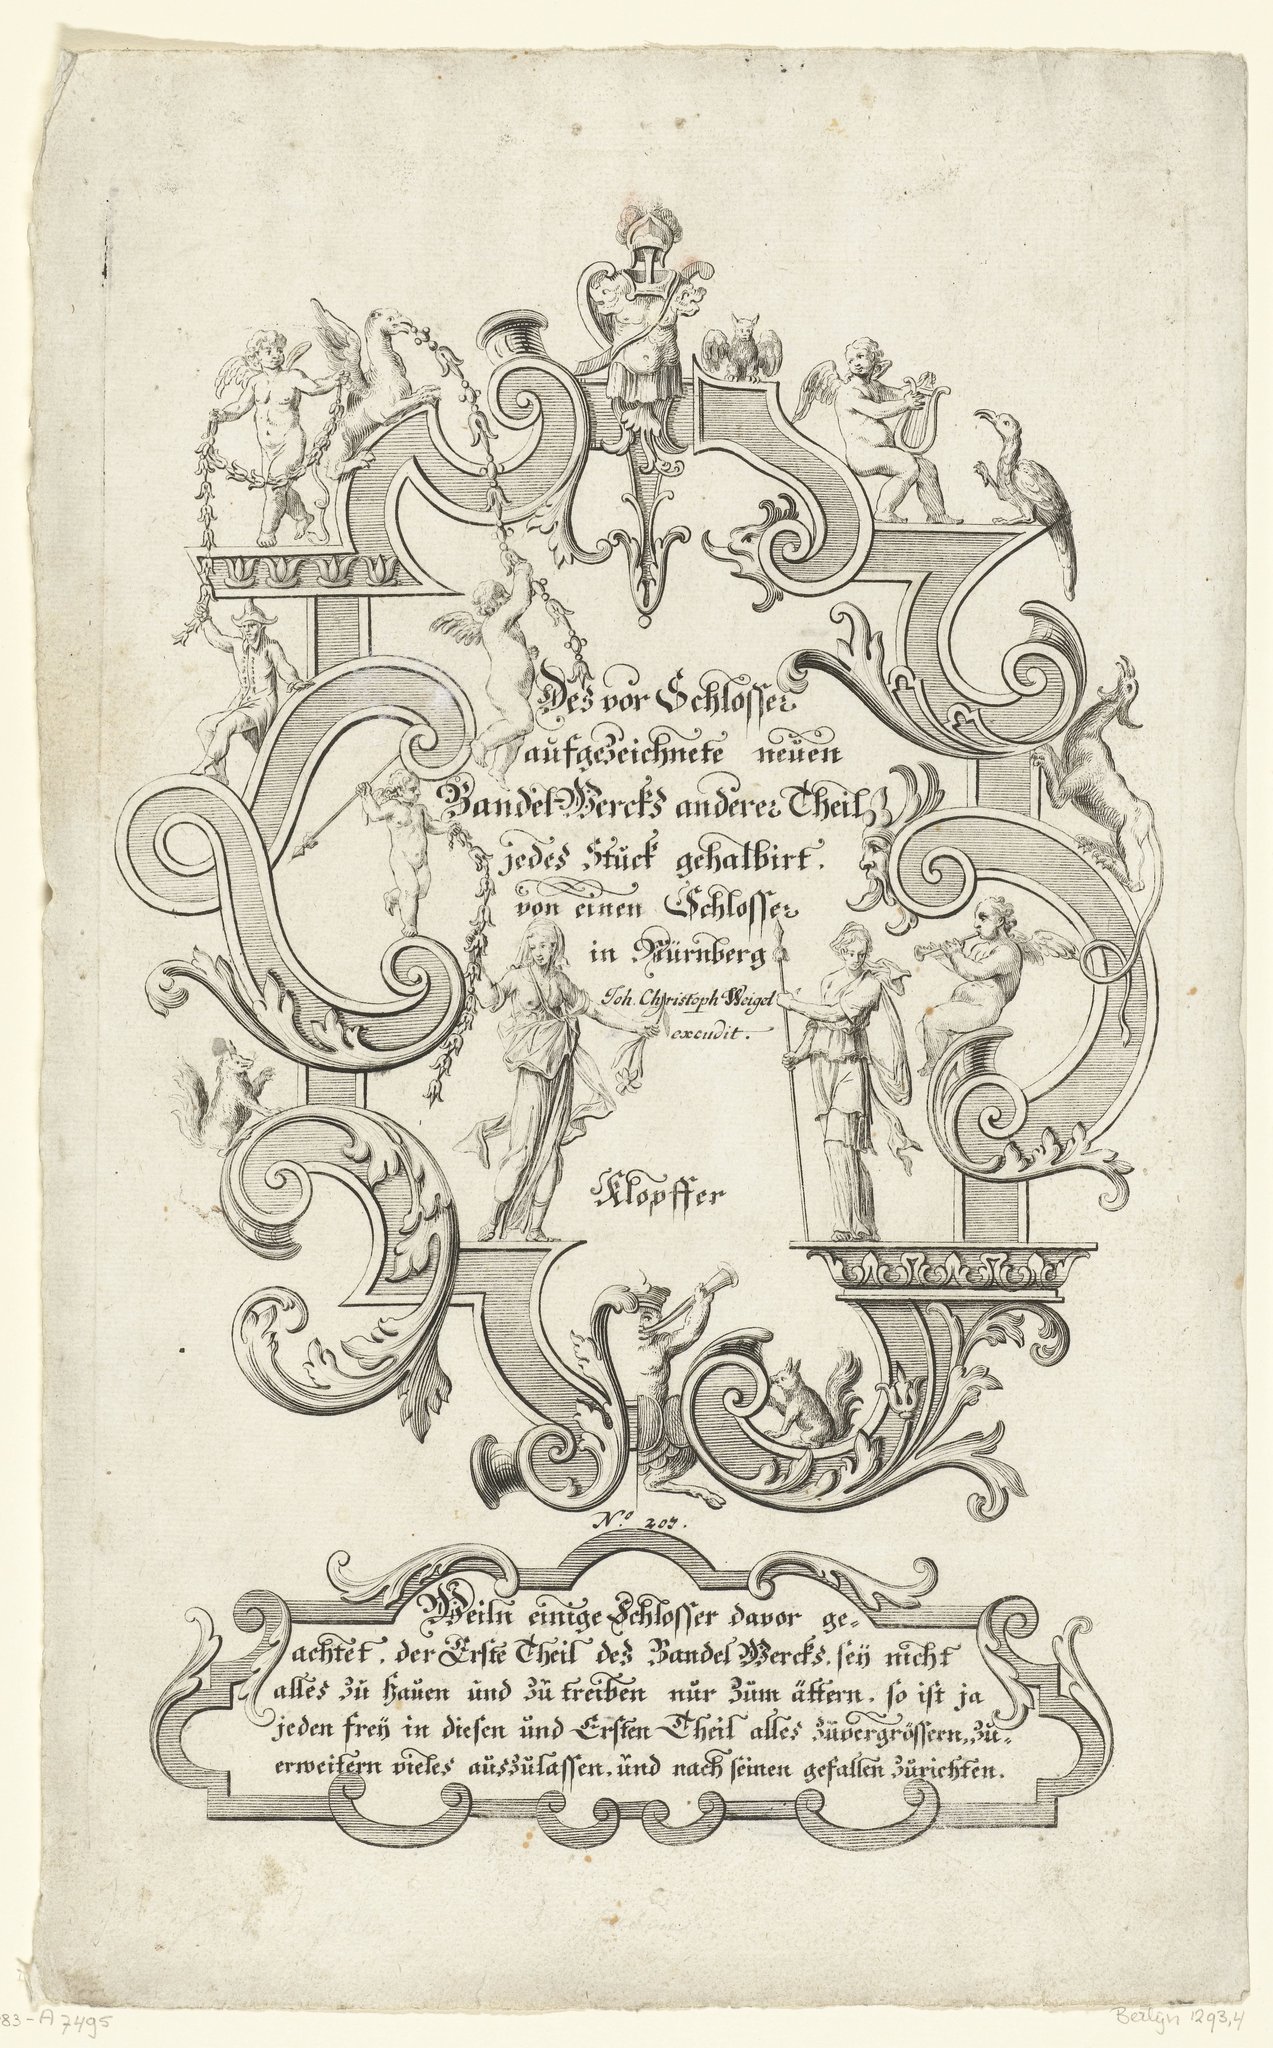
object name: ornament print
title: Des vor Schlosser aufgezeichnete neuen Bandel-Wercks anderer Theil (...)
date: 1600-1699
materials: paper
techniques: etching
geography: germany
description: De tekst staat in twee cartouches van rolwerk met bladranken, dieren en figuren. Tussen de cartouches in staat: N.o 207.